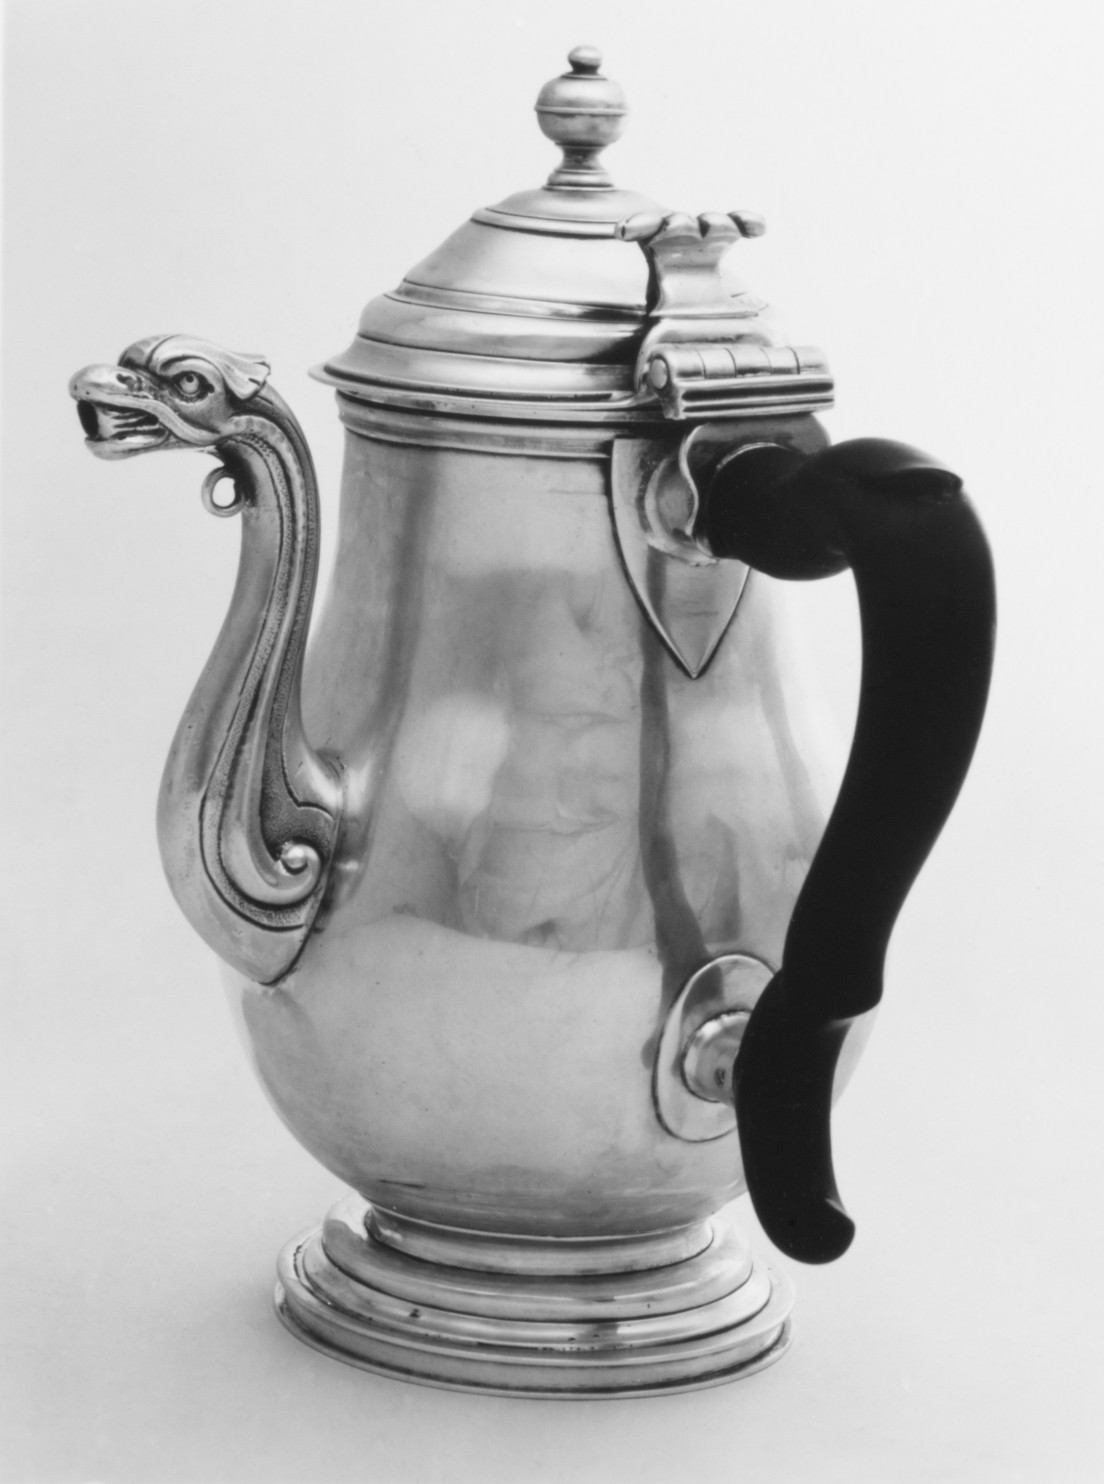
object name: coffeepot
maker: francis garthorne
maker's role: maker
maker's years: 1677-1726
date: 1705-1706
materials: silver, wood